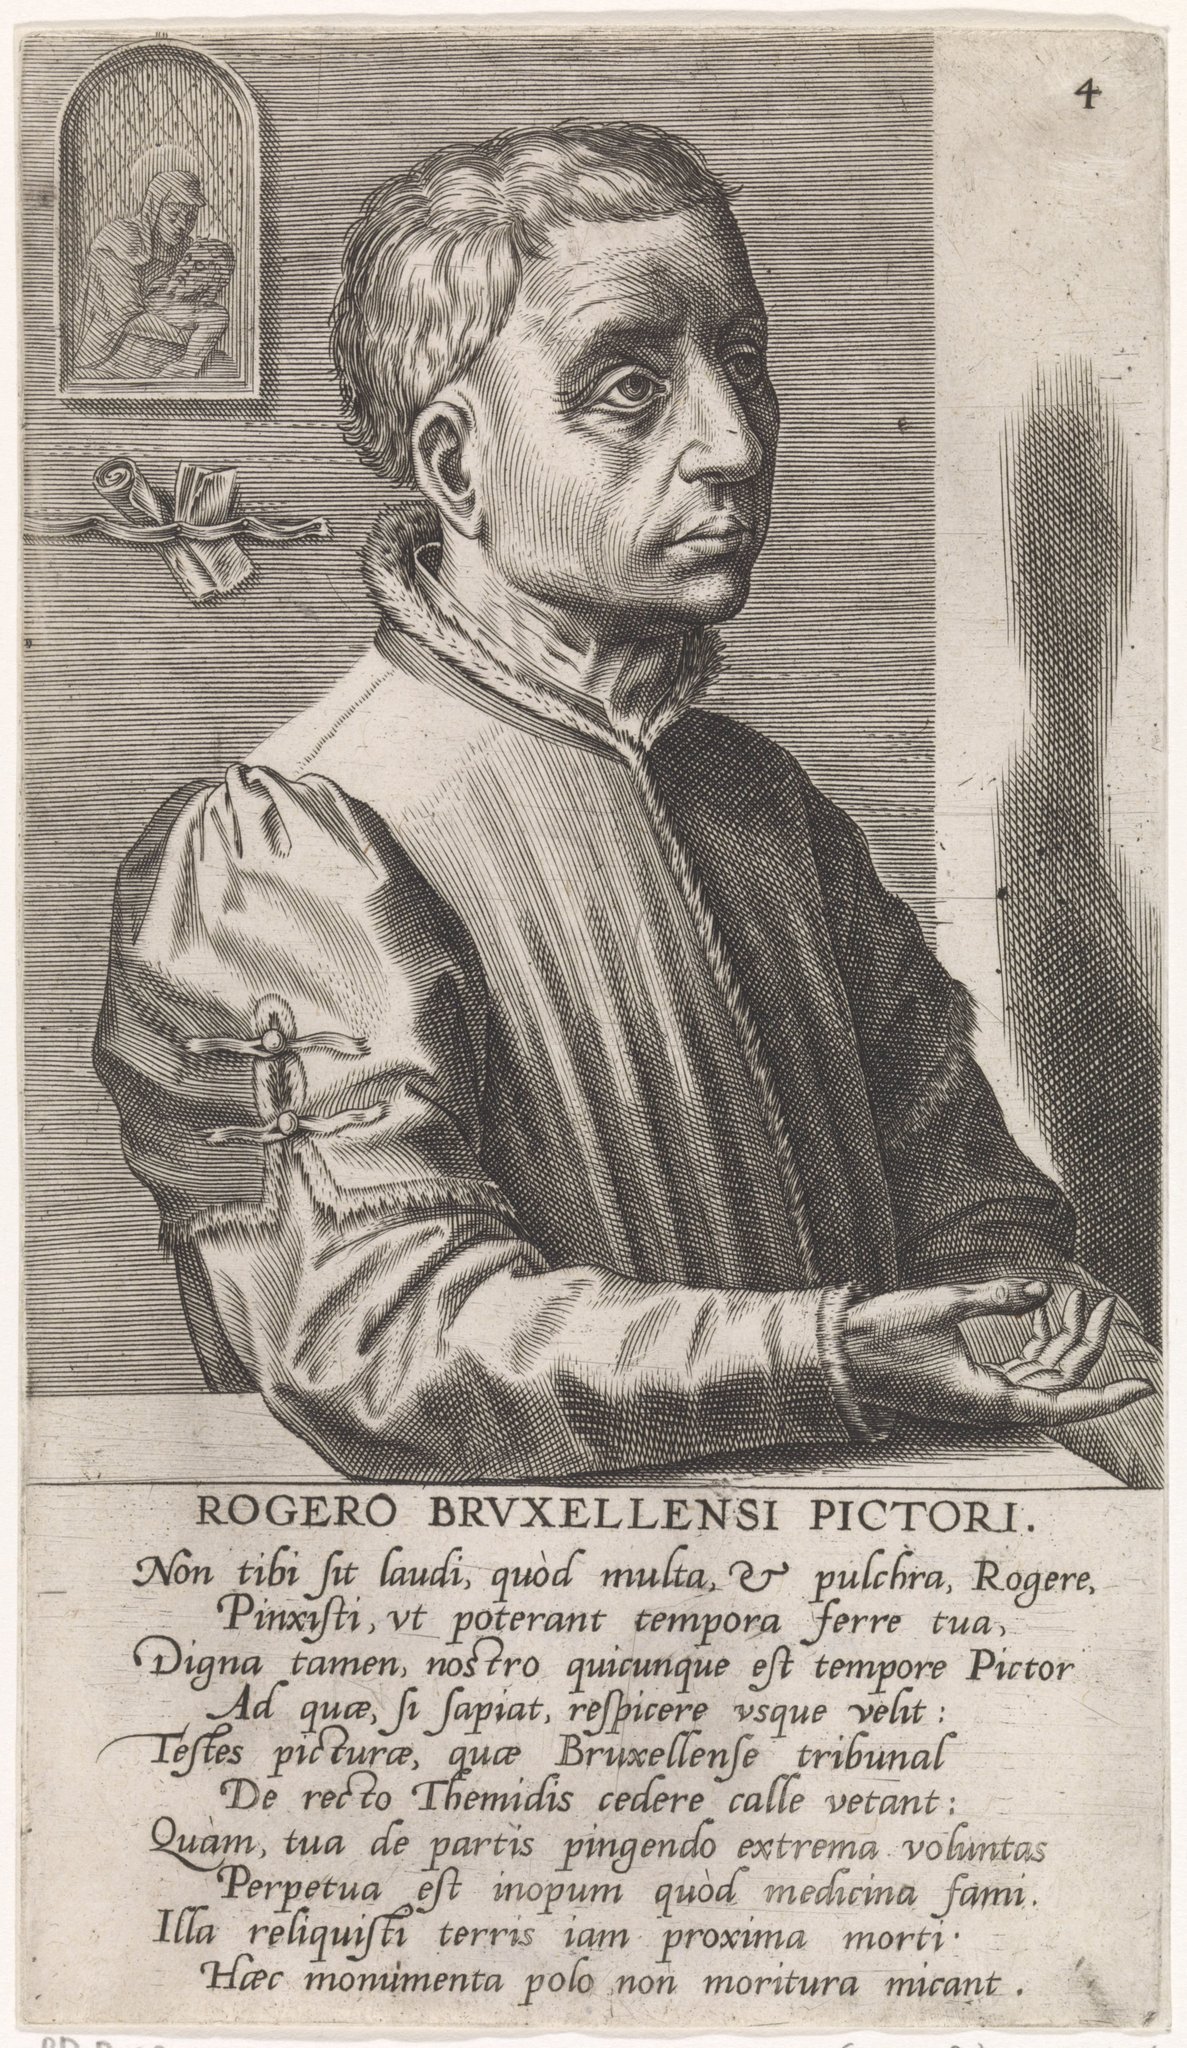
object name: print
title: Rogero Bruxellensi Pictori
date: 1600-1650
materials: paper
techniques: engraving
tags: brussels, painter, rogier van der weyden, portrait, self-portrait of painter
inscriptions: collector's mark: Lugt 964, caption: ‘Non tibi sit...non moritura micant’, title: ‘ROGERO BRUXELLENSI PICTORI’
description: Latere staat van prent gebruikt in: Sebastiano Resta, The True Effigies of the most eminent Painters and other Famous Artists that have Flourished in Europe Curiously Engraven on 125 Copper Plates, 1694.